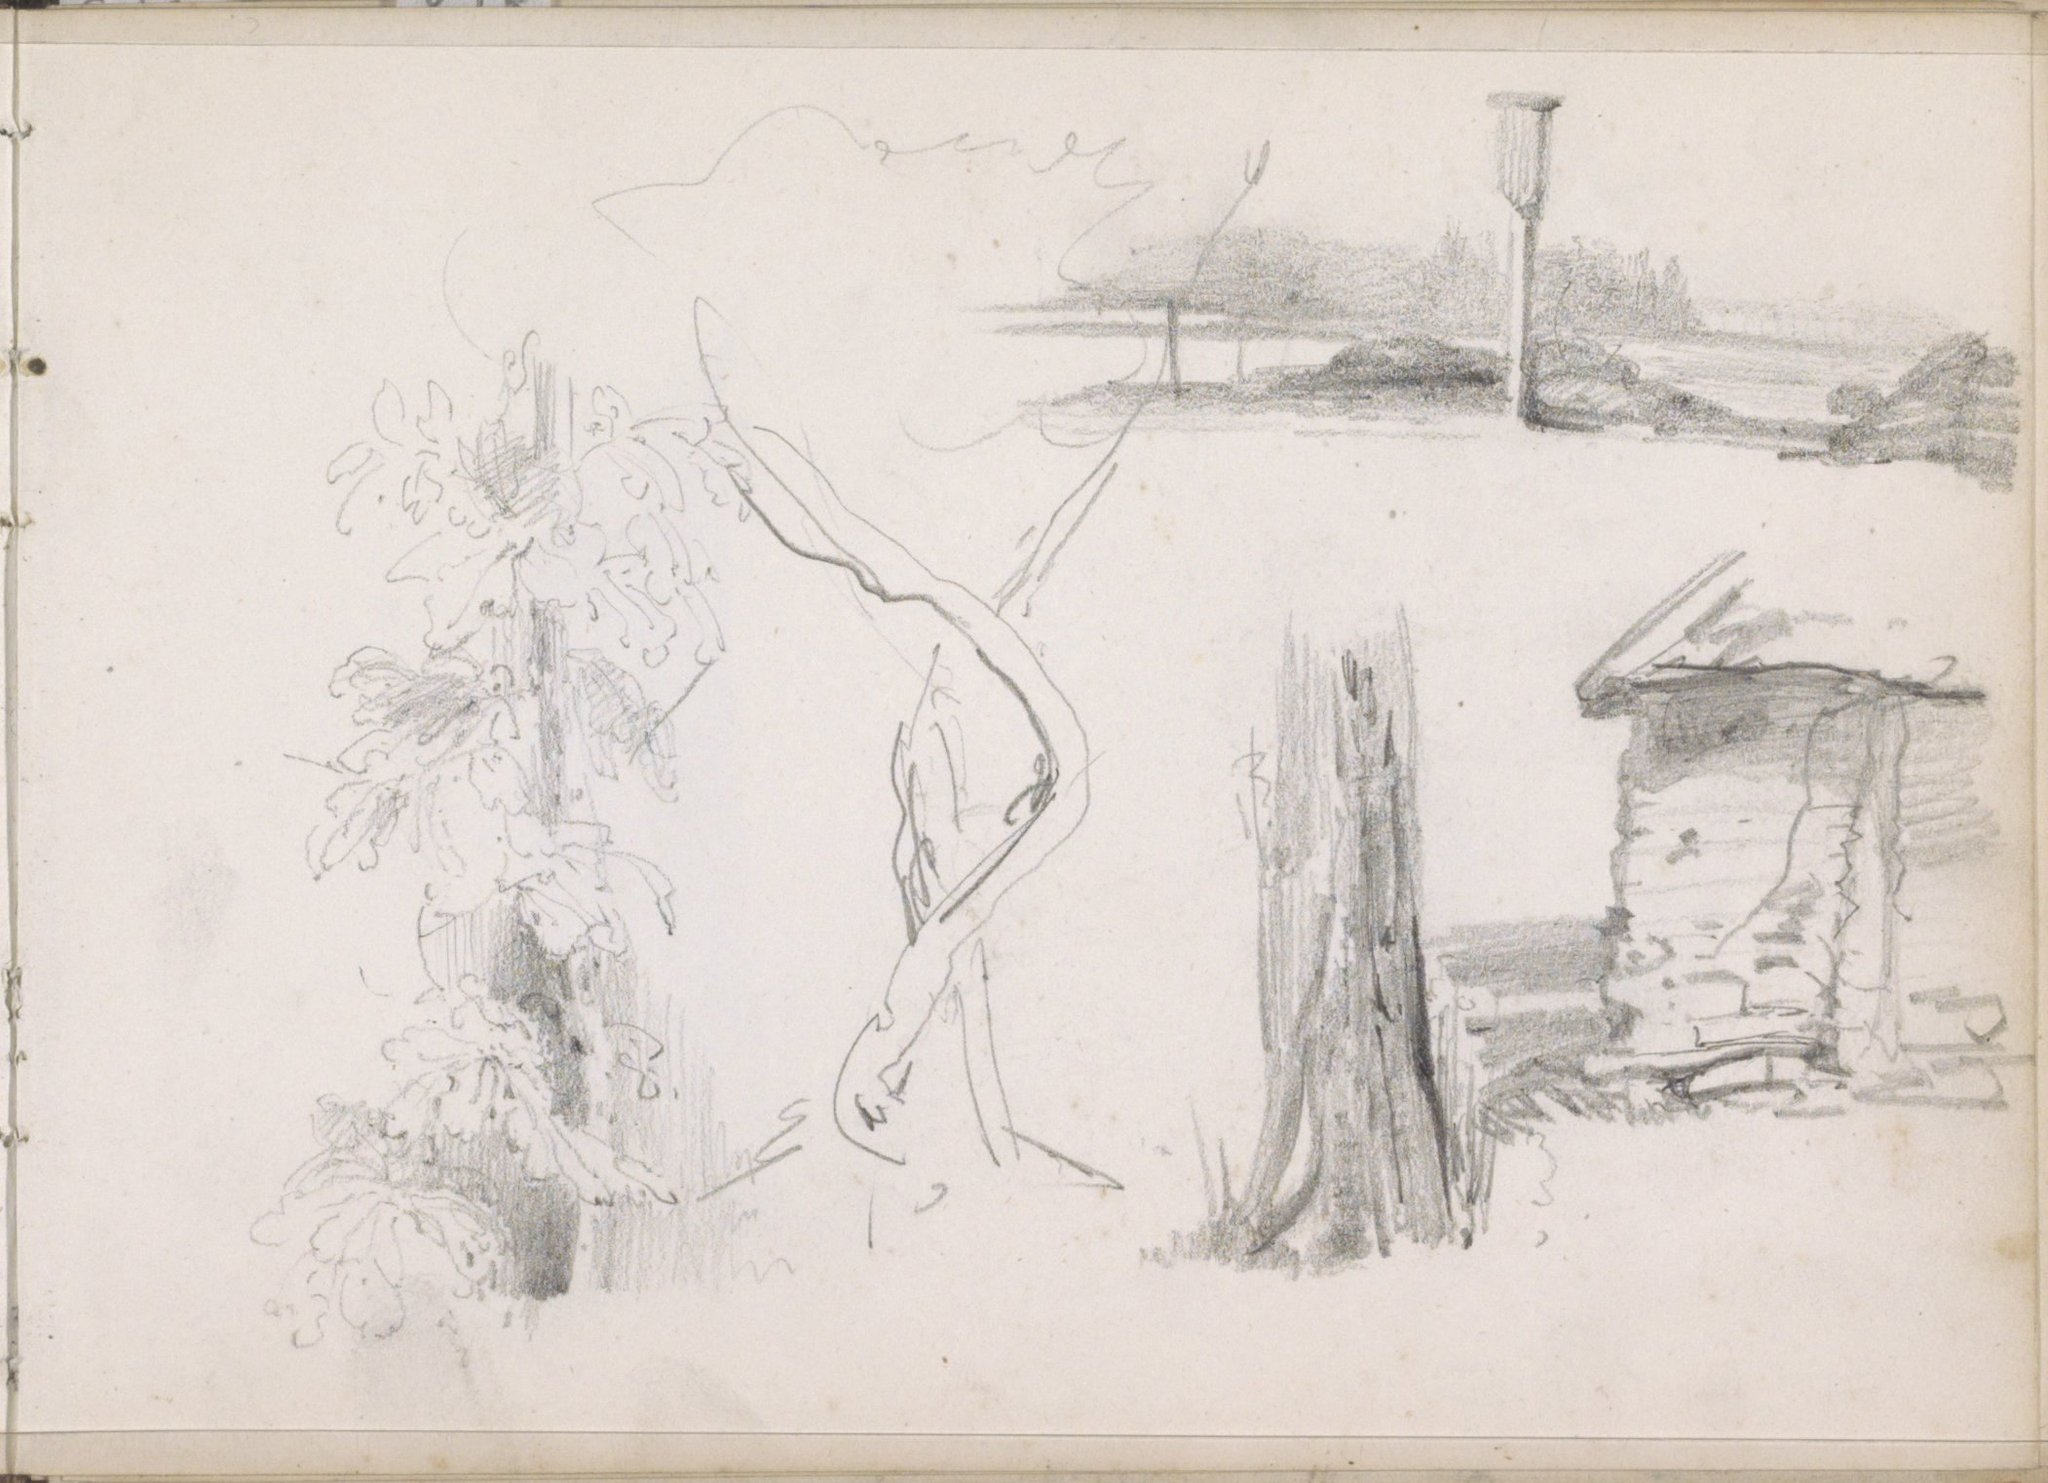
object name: sketchbook leaf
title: Studieblad, onder andere met een boomstam, landschap en tak in bloei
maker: maria vos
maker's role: draughtsman, painter, print maker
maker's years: 1824-1906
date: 1834-1906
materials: paper, pencil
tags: landscapes, trees (+ stem, trunk), plants; vegetation (+ branch, stick)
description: Blad 3 recto uit een schetsboek met 30 bladen.